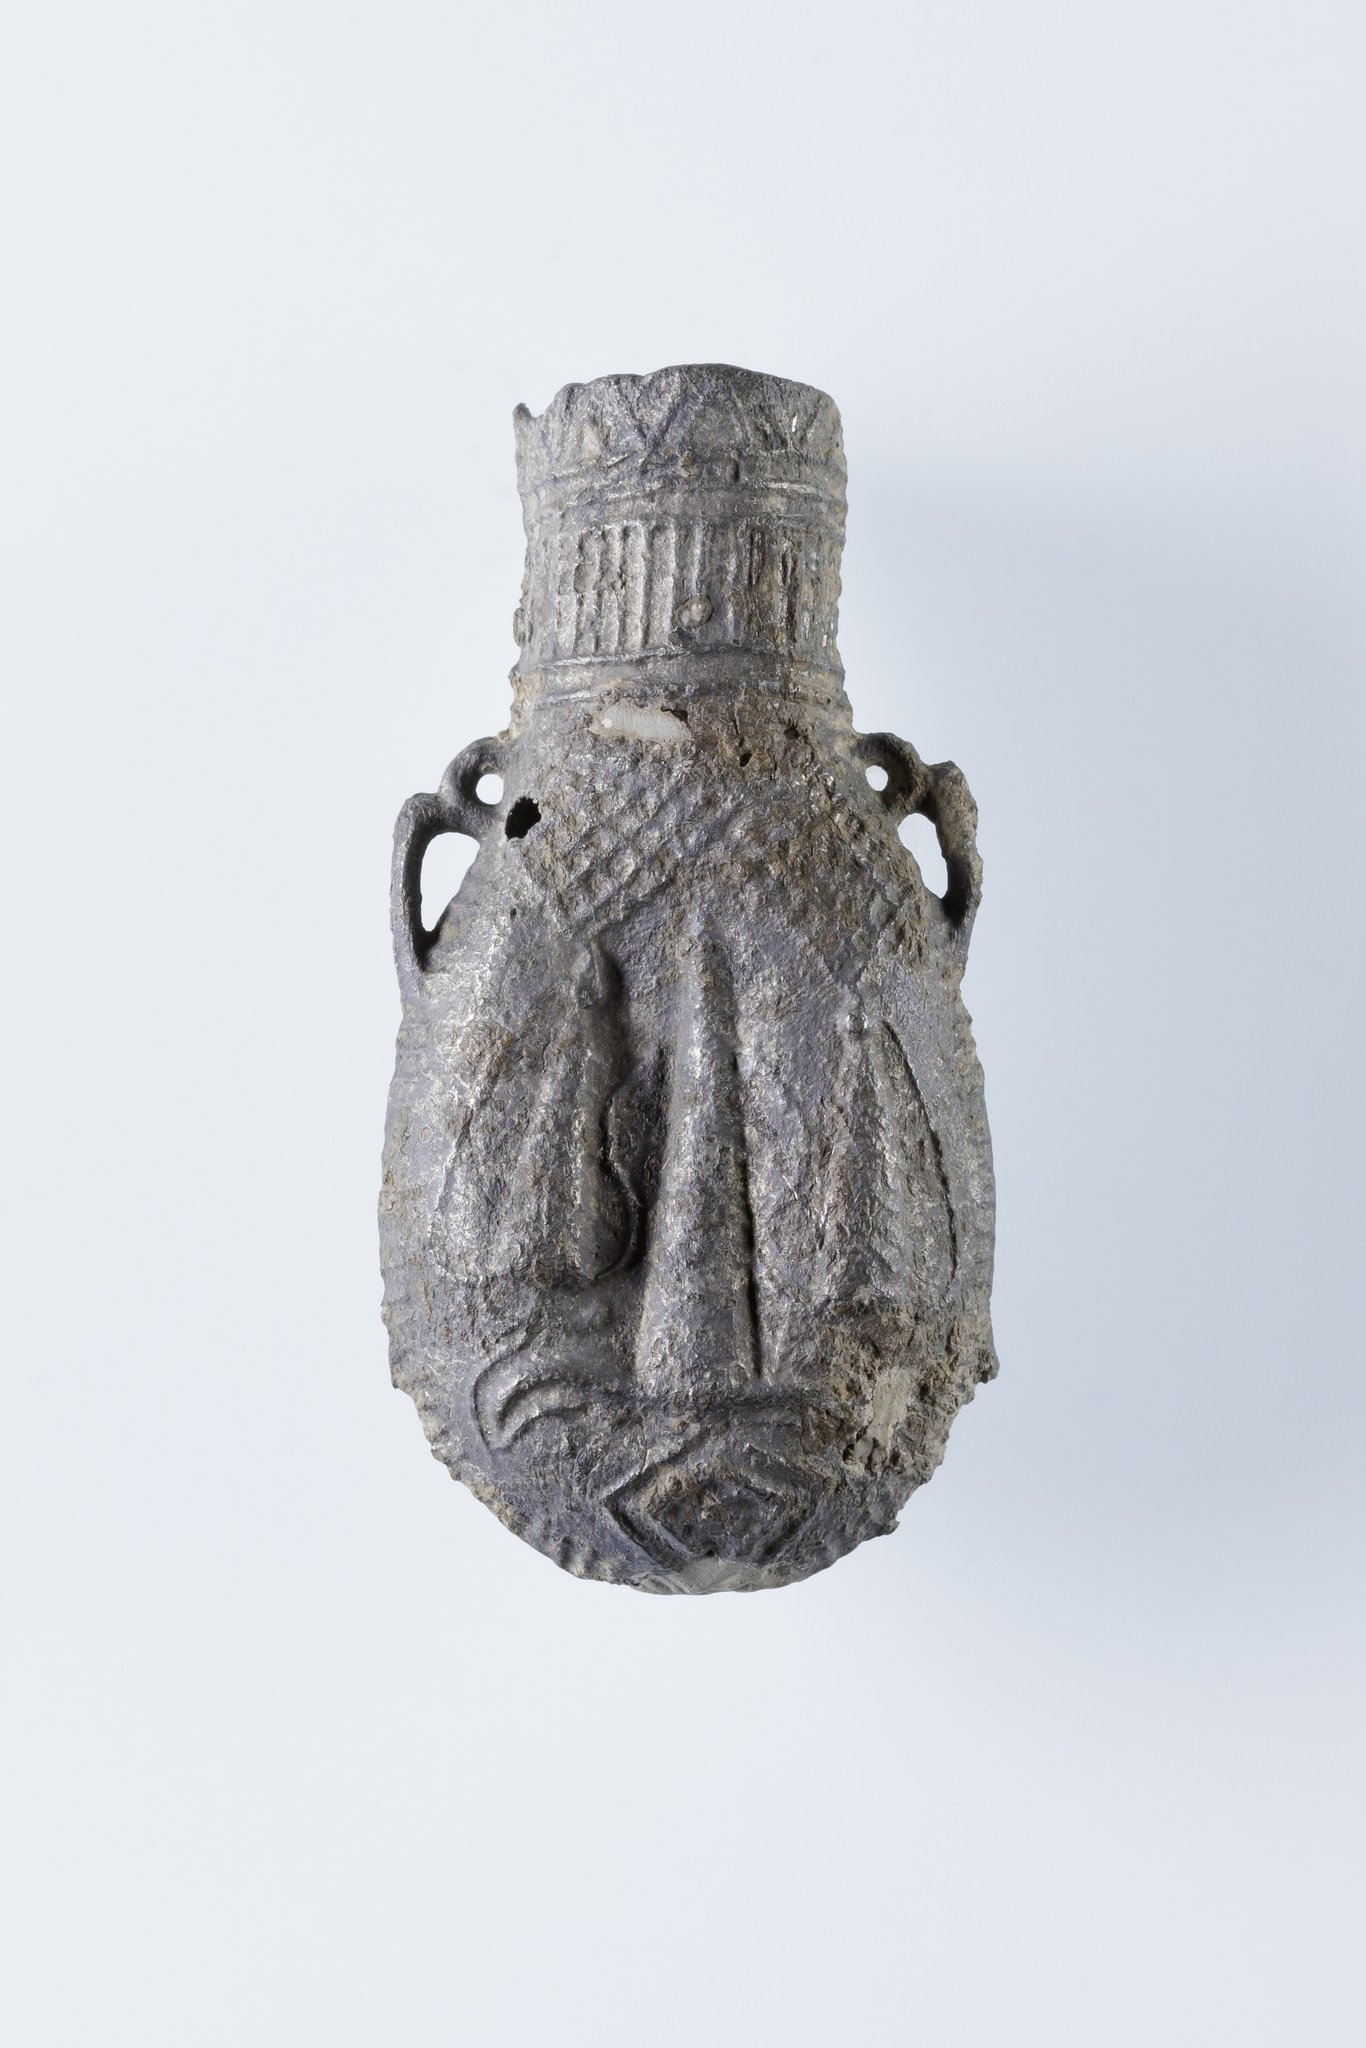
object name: vial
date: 401-500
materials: tin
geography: egypt